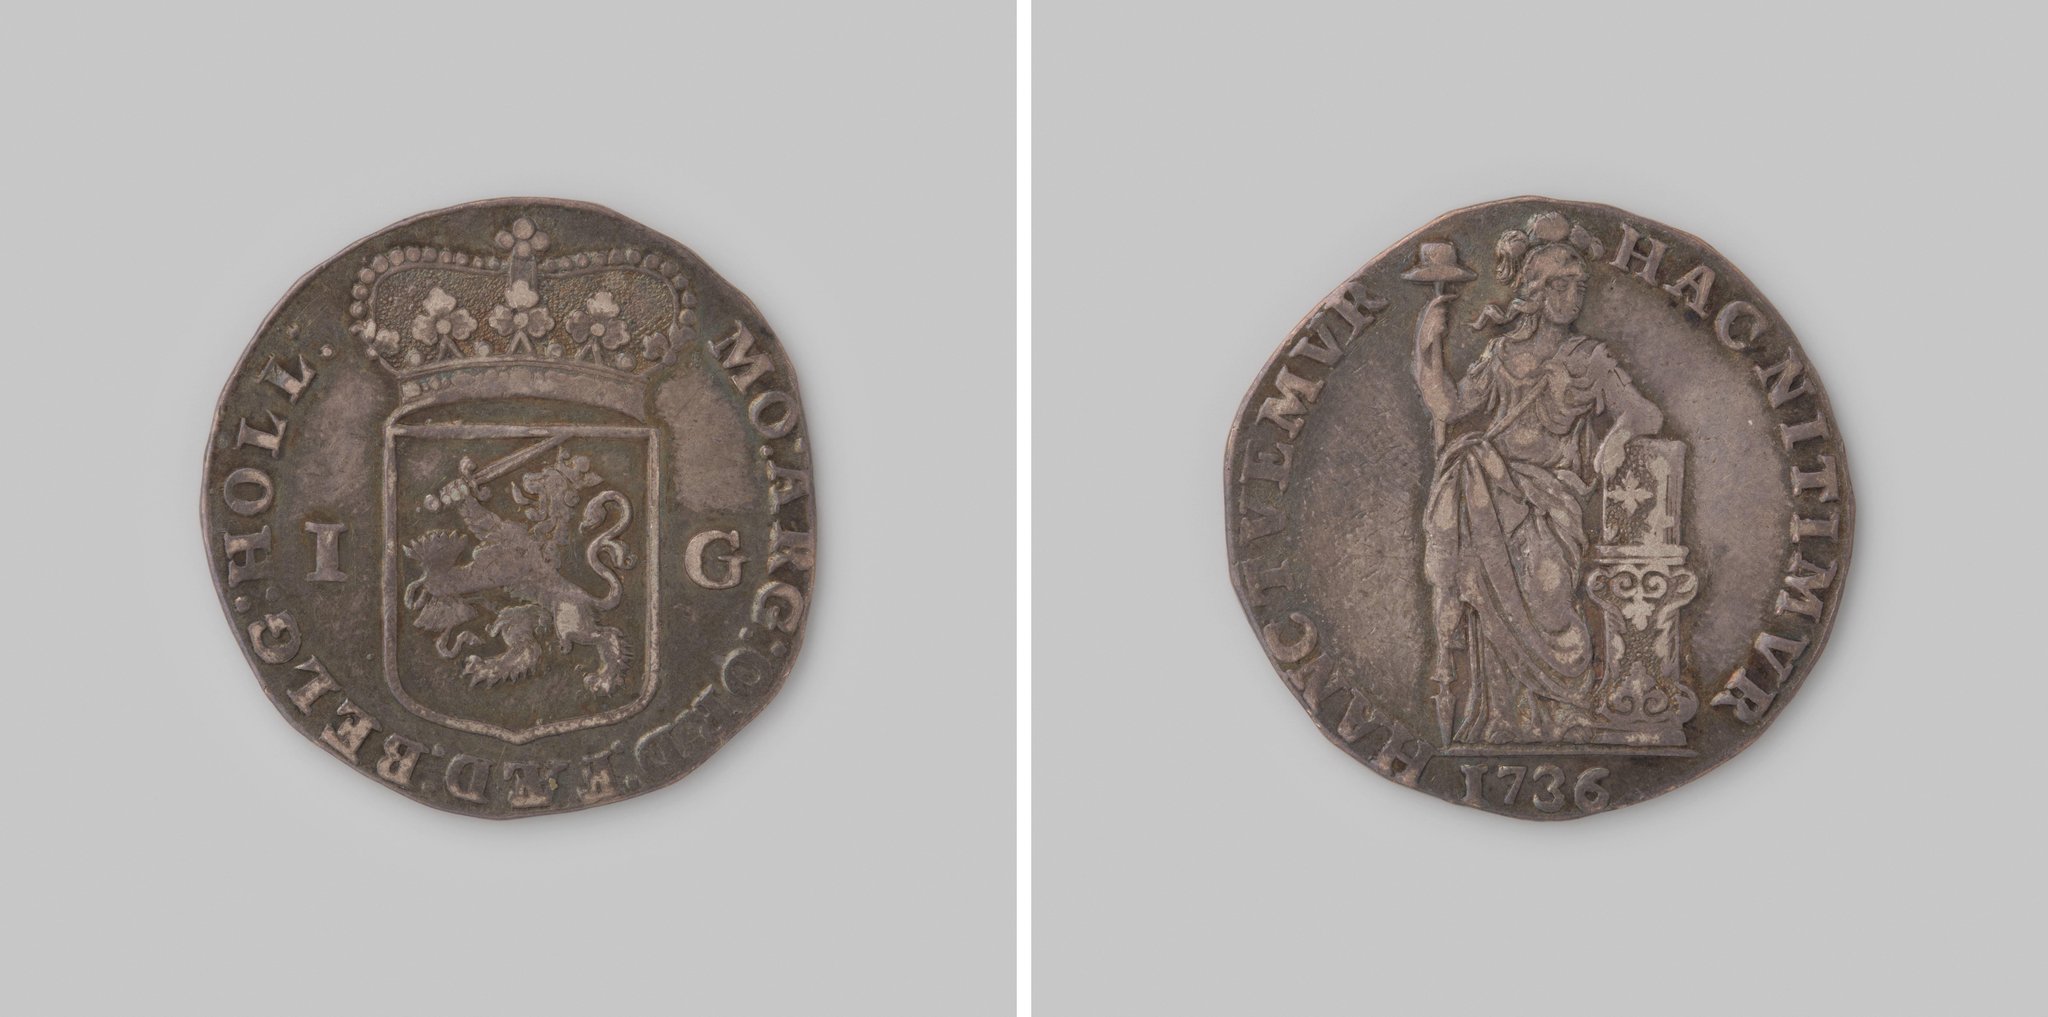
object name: coin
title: Hollandse gulden, 1736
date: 1736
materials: silver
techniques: striking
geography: dordrecht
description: Zilveren munt. Voorzijde: tussen waarde-aanduiding gekroond generaliteitswapenschild. Keerzijde: staande Nederlandse maagd met in rechterhand speer, waarop hoed en met linkerhand steunend op altaar, waarop bijlbel. In afsnede jaartal.